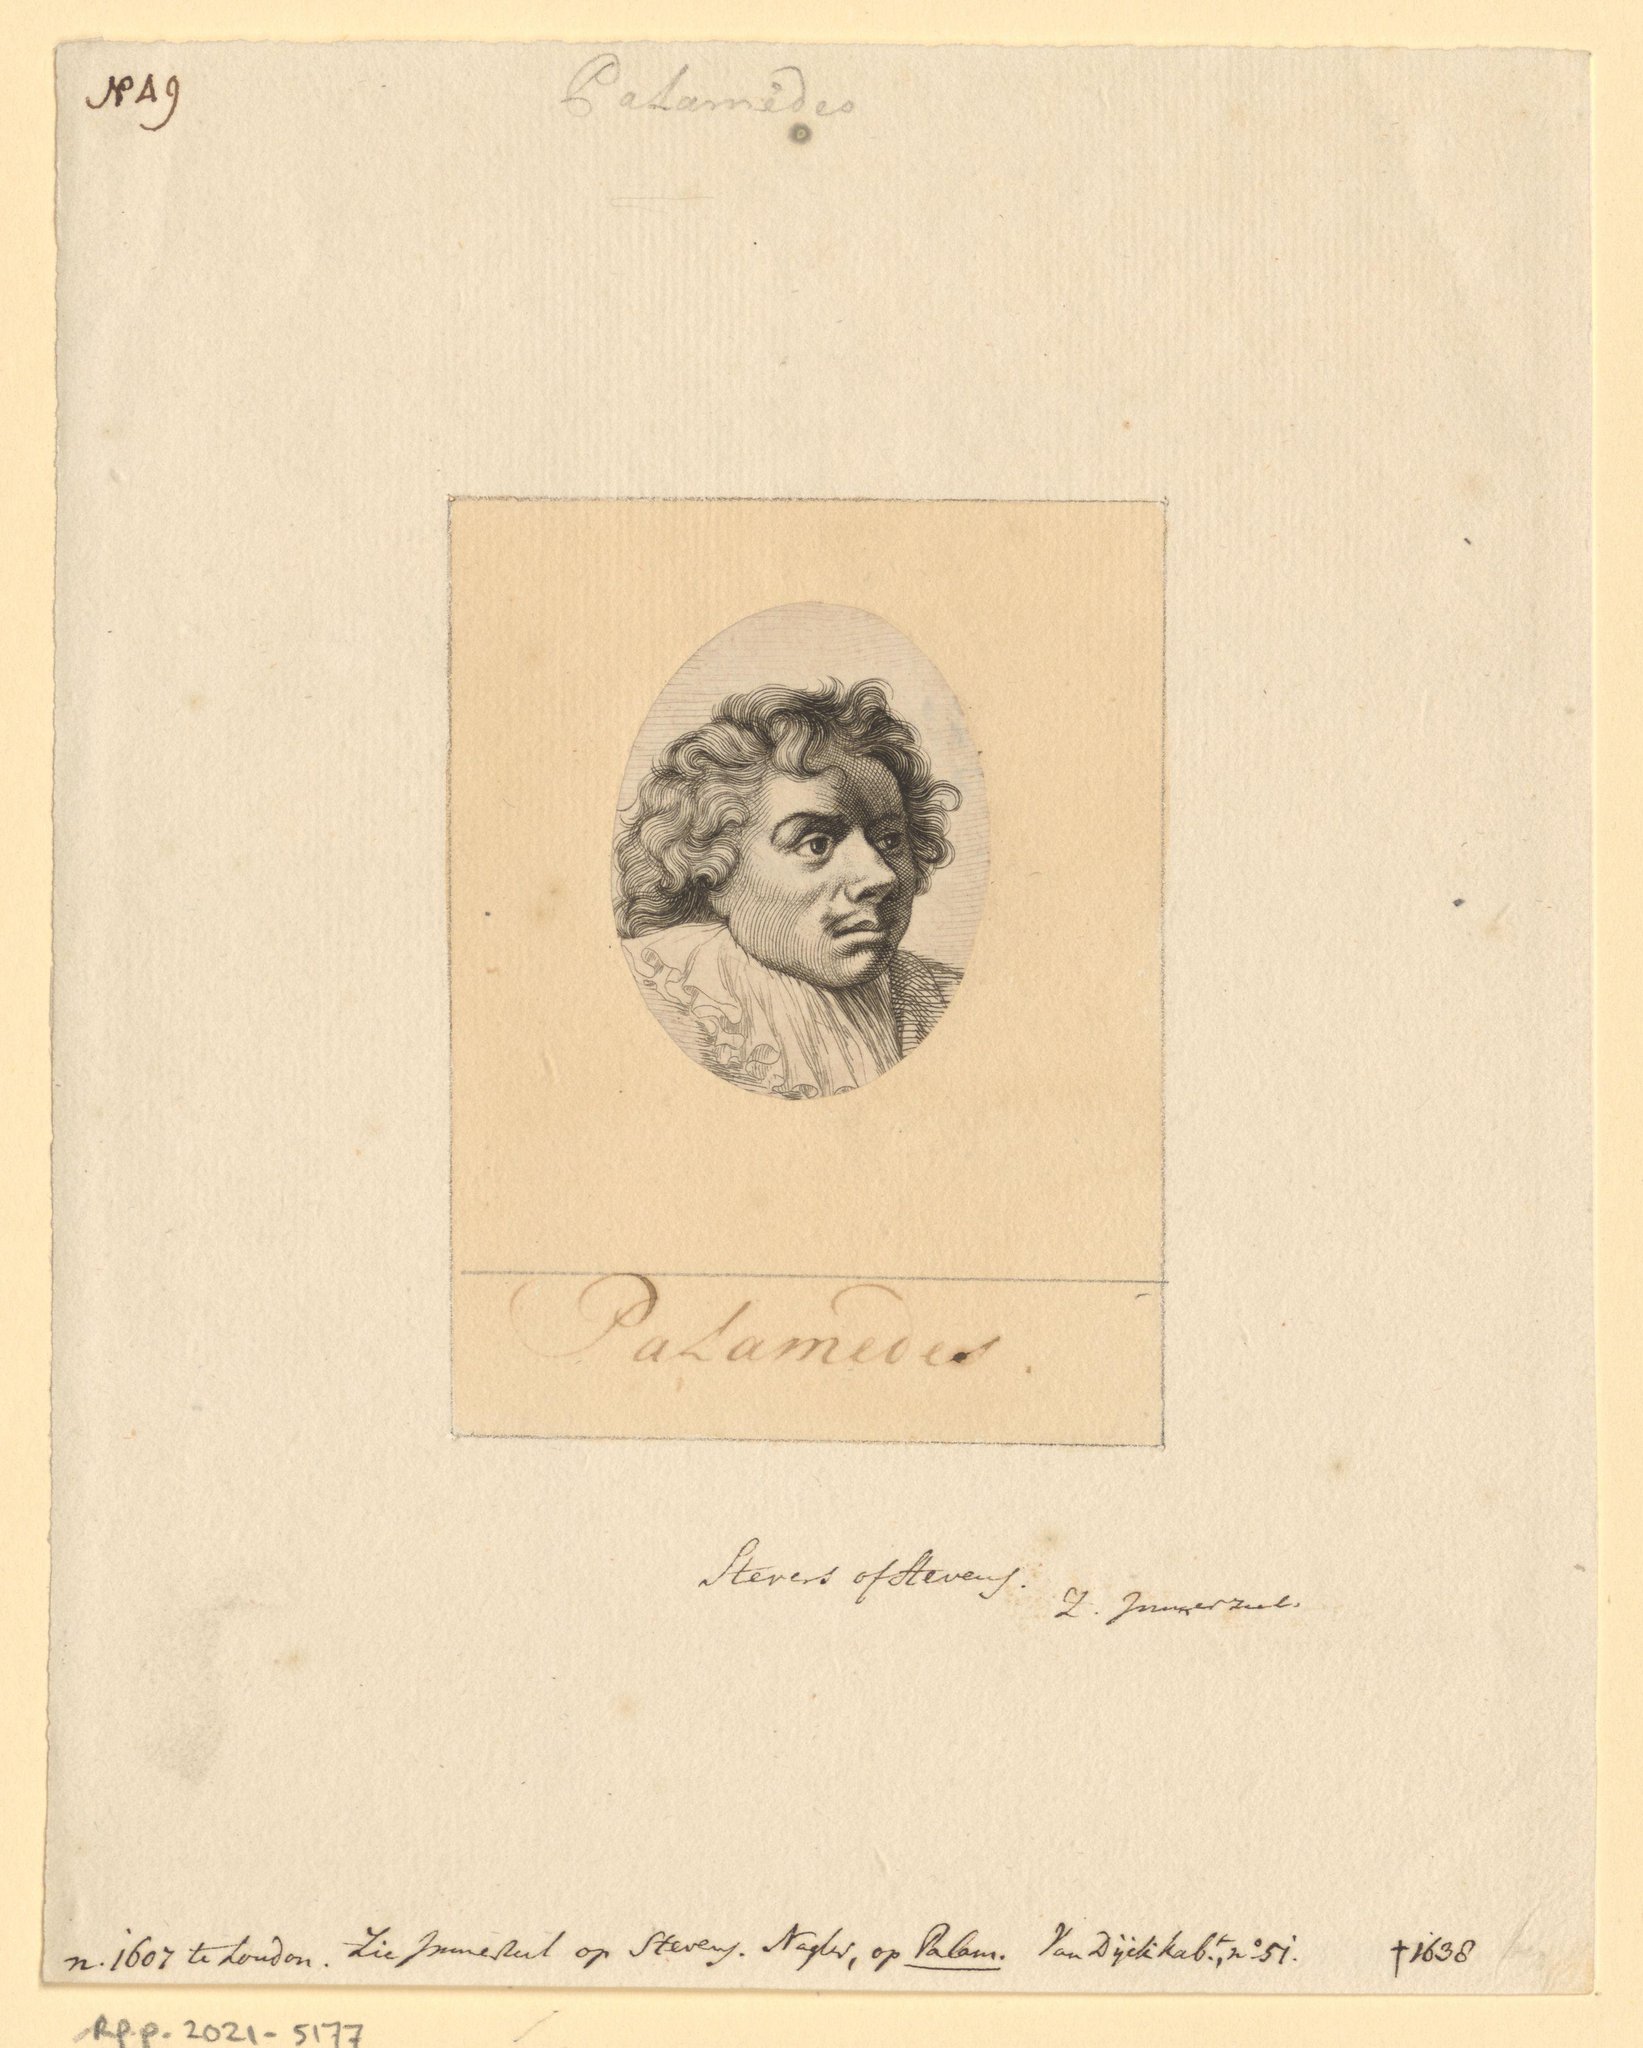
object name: book illustration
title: Portret van Palamedes Palamedesz. I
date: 1718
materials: paper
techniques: engraving, etching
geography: amsterdam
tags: delft, painter, palamedes palamedesz. (i), adult man, historical persons, portrait, self-portrait of painter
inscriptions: inscription: ‘Palamedes/ Steven of Stevens/ Z Immerzeel/ n. 1607 te Londen (...) 1638’, collector's mark: Lugt 2228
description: Deze prent is een uitgeknipt detail van een prent uit: Houbraken, Arnold. De groote schouburgh der Nederlantsche konstschilders en schilderessen (...). Amsterdam: Arnold Houbraken, 1718, dl. 1.